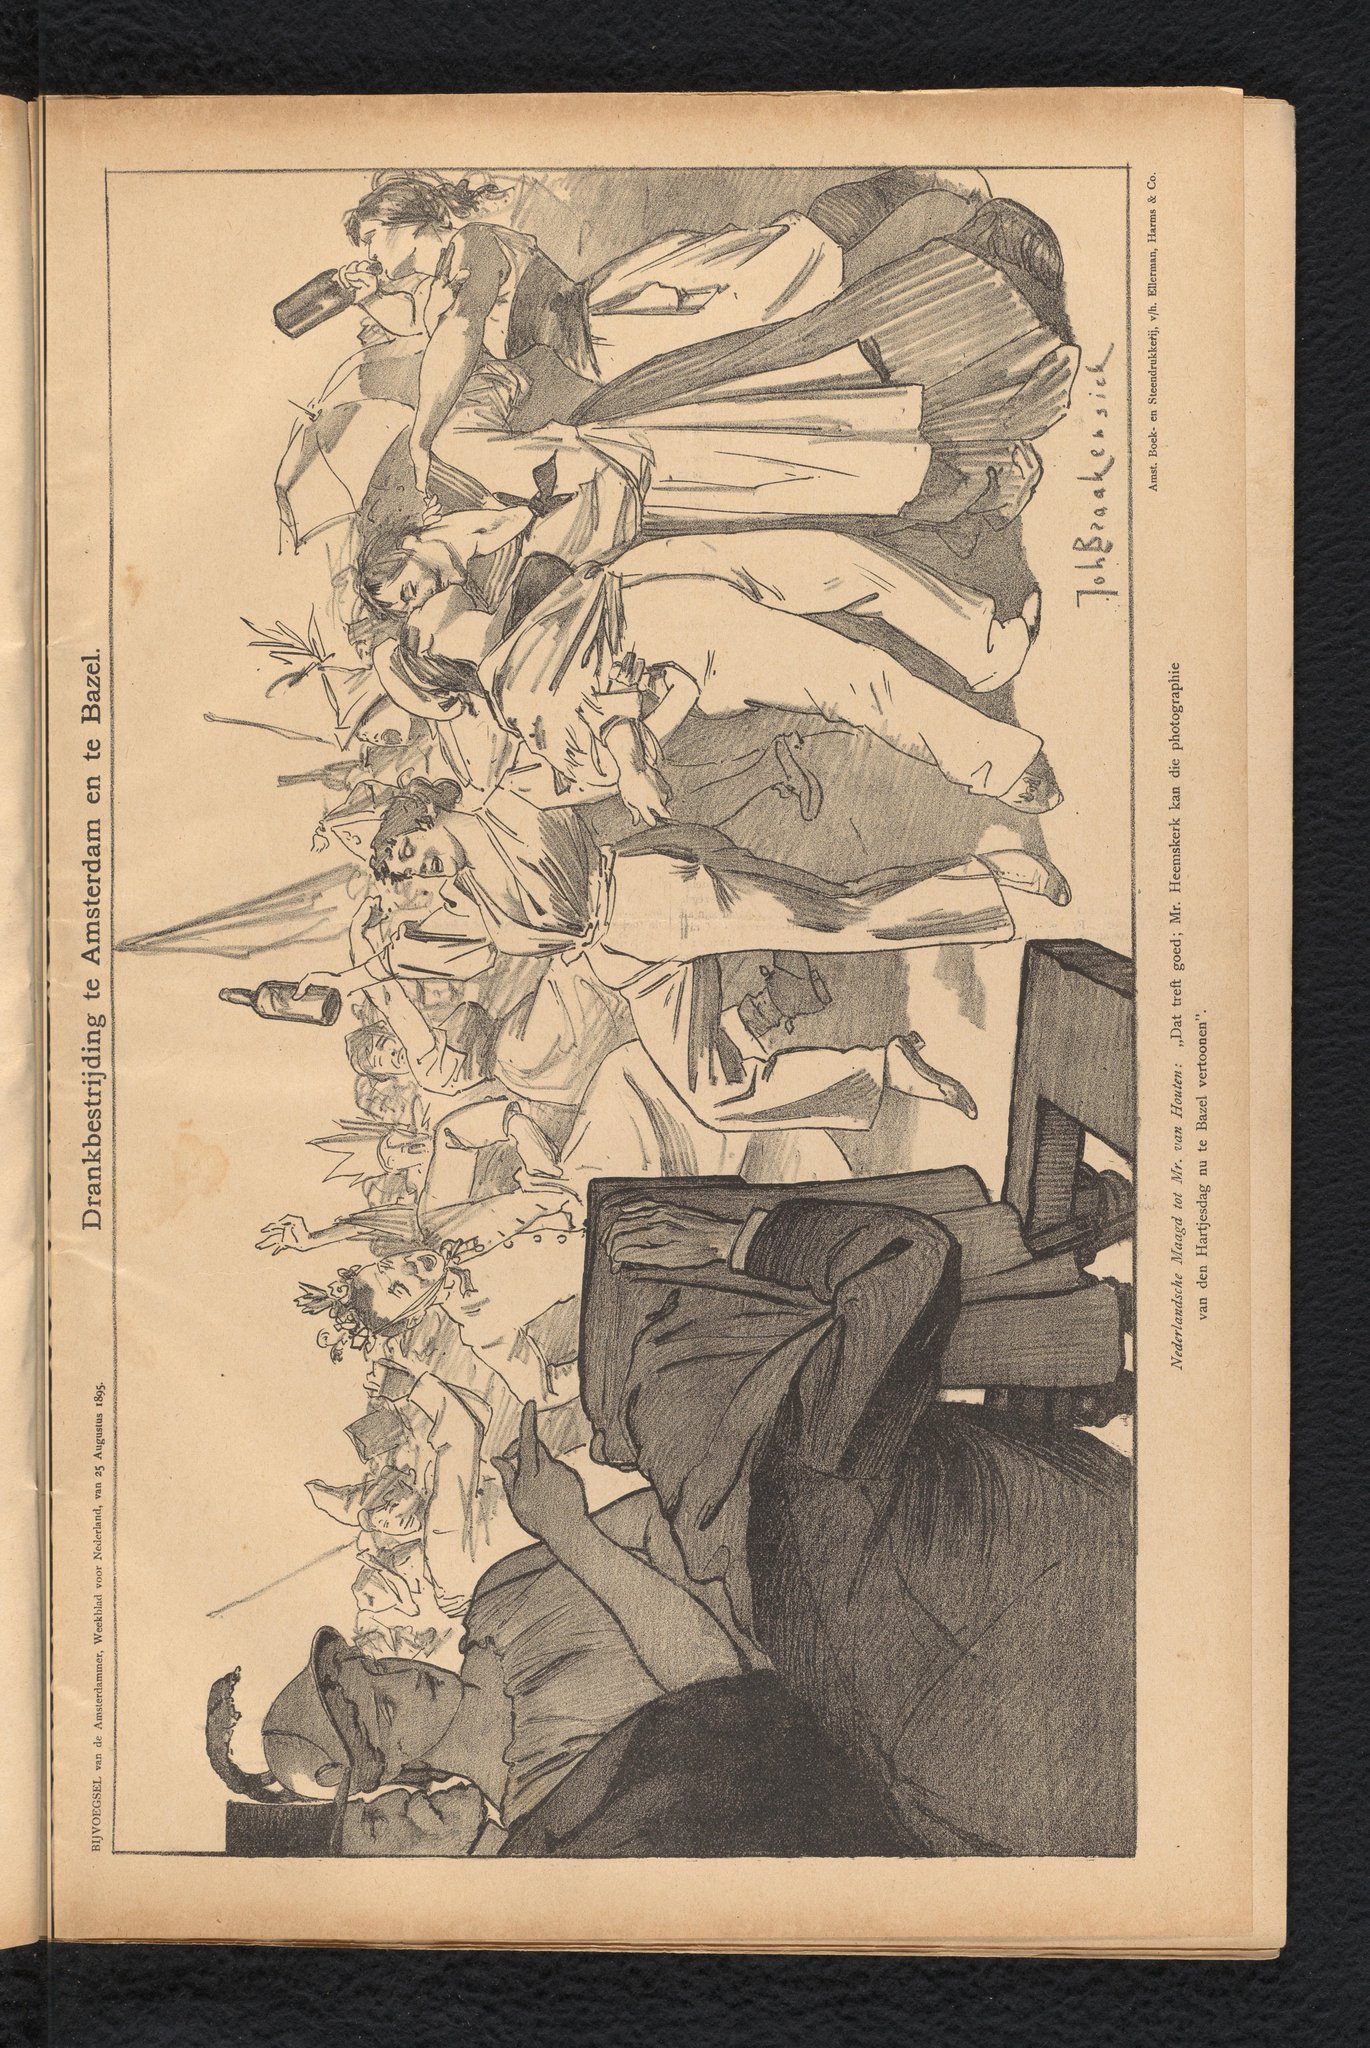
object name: cartoon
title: Drankbestrijding te Amsterdam en te Bazel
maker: johan braakensiek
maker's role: draughtsman, print maker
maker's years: 1858-1940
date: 1895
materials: paper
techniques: lithograph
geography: amsterdam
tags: amsterdam, the hague, samuel van houten, woman dressed as man, travesty, man dressed as woman, travesty, personifications of countries, nations, states, districts, etc., carousal, drinking-bout, orgy - cc - out of doors, taking photographs, political caricatures and satires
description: De Nederlandse Maagd en minister van Binnenlandse Zaken Sam van Houten bij een fotograaf Mr. Heemskerk die een foto maakt van een uitzinnige groep feestvierders die Hartjesdag (derde maandag in augustus) vieren. Met veel drank en mannen in vrouwenkleren en vice versa. Mr. Jan Heemskerk Azn. bepleitte op een internationaal congres in Bazel het Nederlandse regeringsbeleid in zake drankbestrijding.